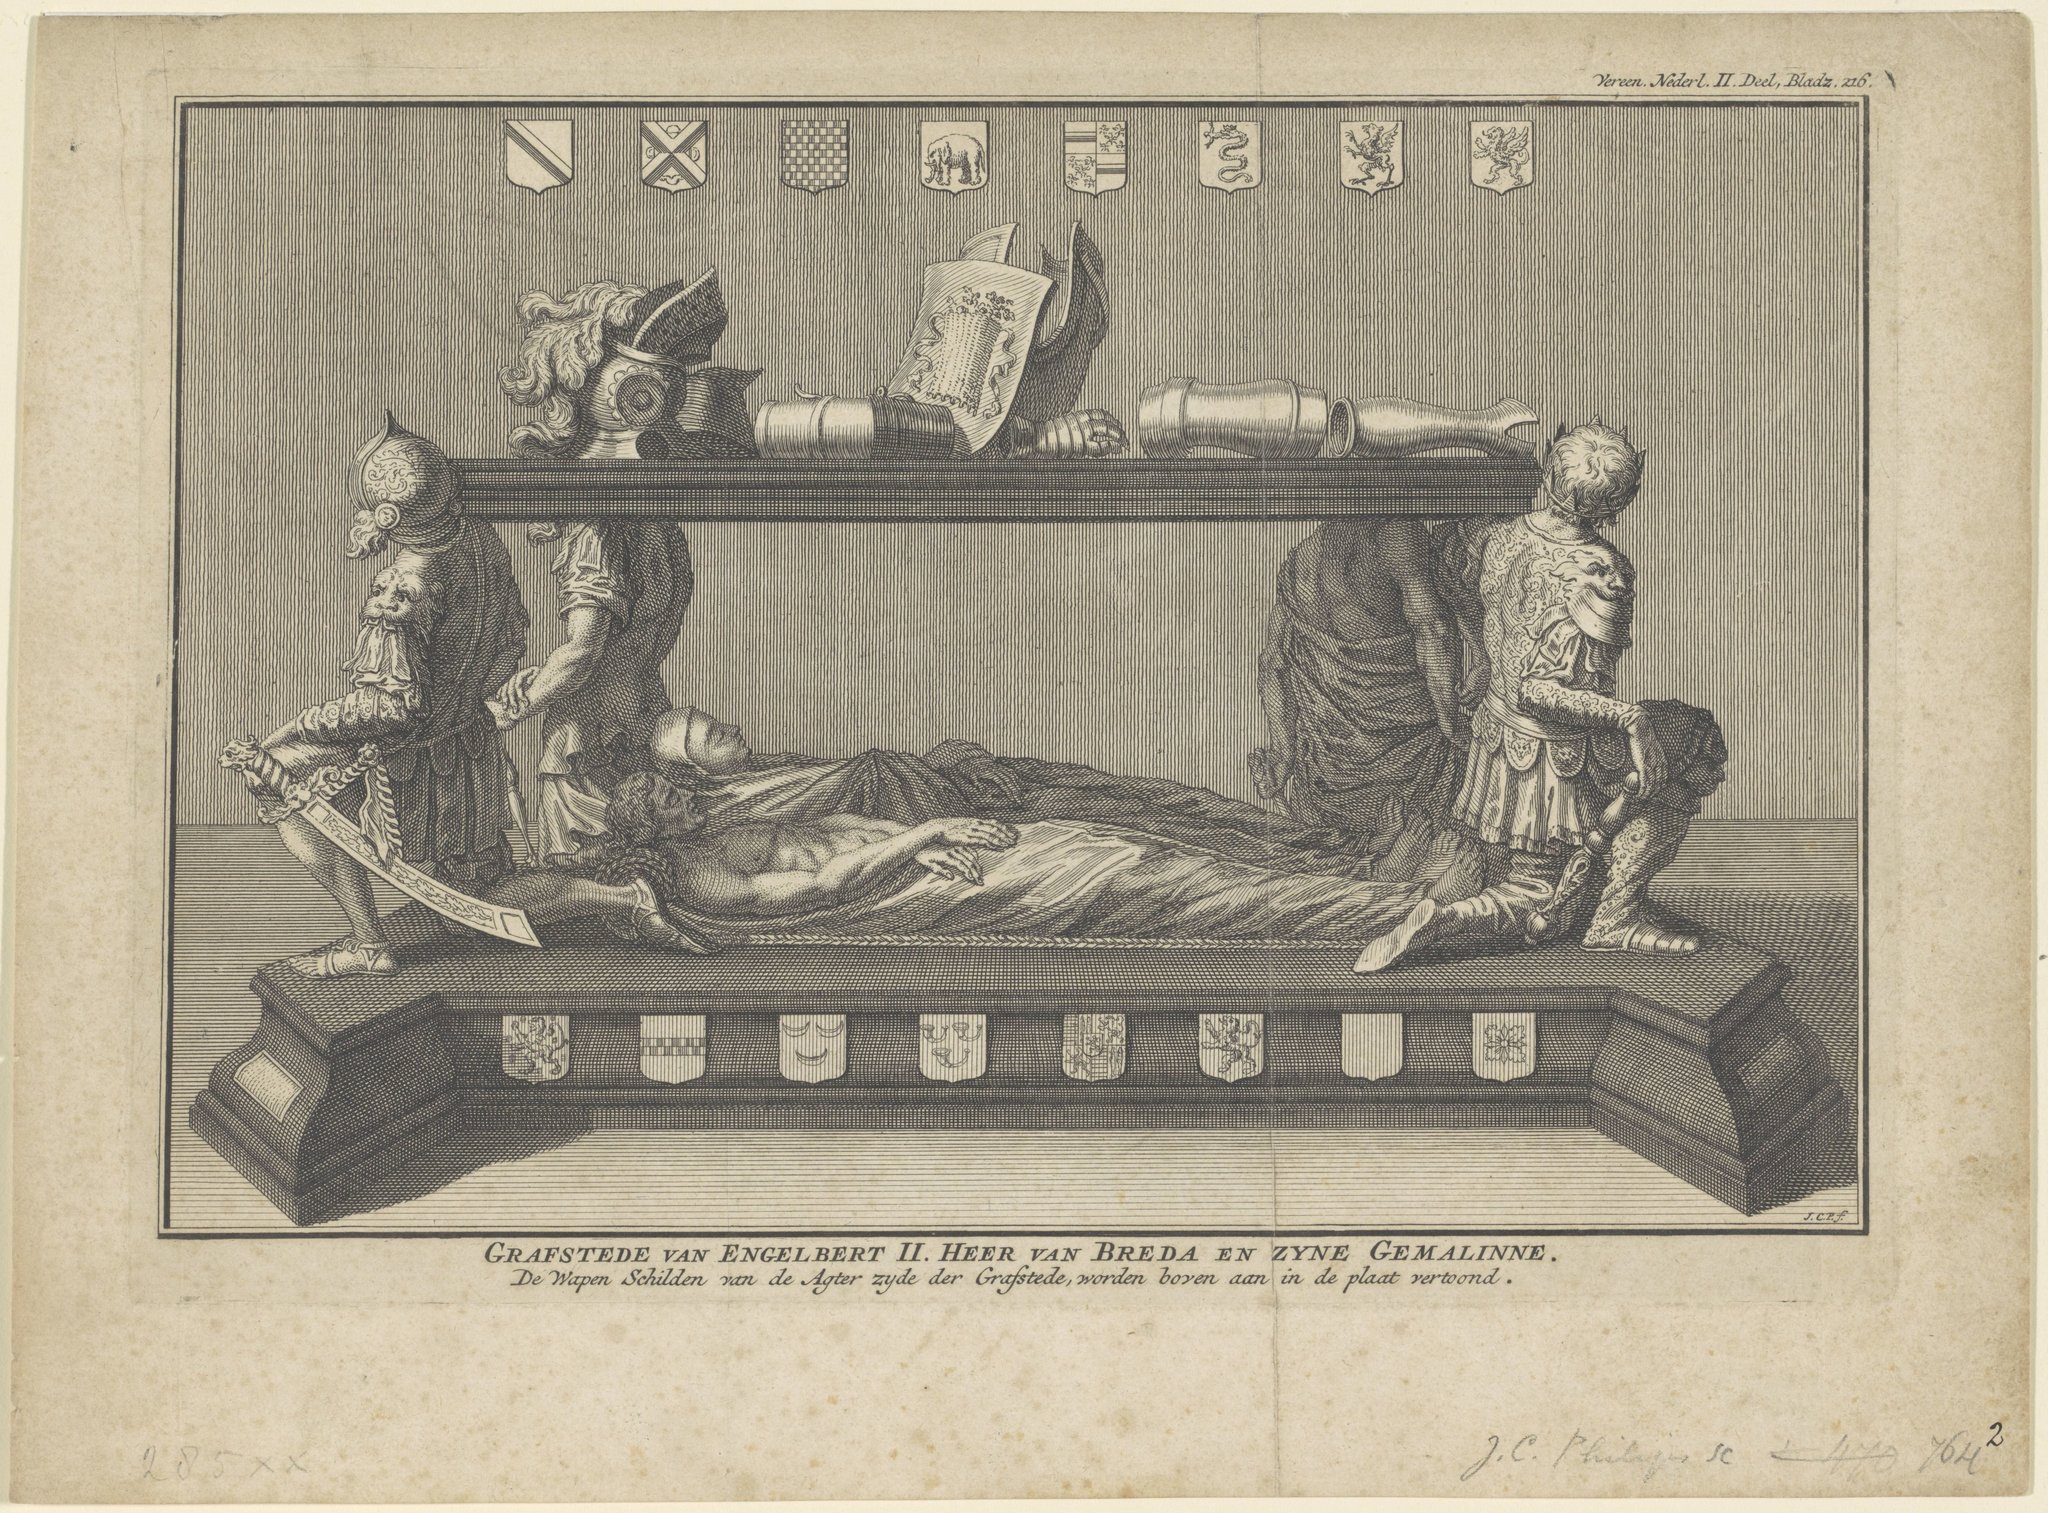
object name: book illustration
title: Grafmonument voor Engelbrecht II, graaf van Nassau-Dillenburg-Breda, 1504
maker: jan caspar philips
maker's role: draughtsman, print maker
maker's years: 1700-1775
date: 1736-1775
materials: paper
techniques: engraving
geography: amsterdam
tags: grave-building, monumental tomb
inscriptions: collector's mark: Lugt 963, collector's mark: Lugt 2166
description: Grafmonument voor Engelbrecht II in de Prinsenkapel van de Onze-Lieve-Vrouwekerk te Breda, overleden op 31 mei 1504. In de ondermarge twee regels Nederlandse tekst. Rechtsboven 'Vereen. Nederl. II. Deel, Bladz. 216.'.